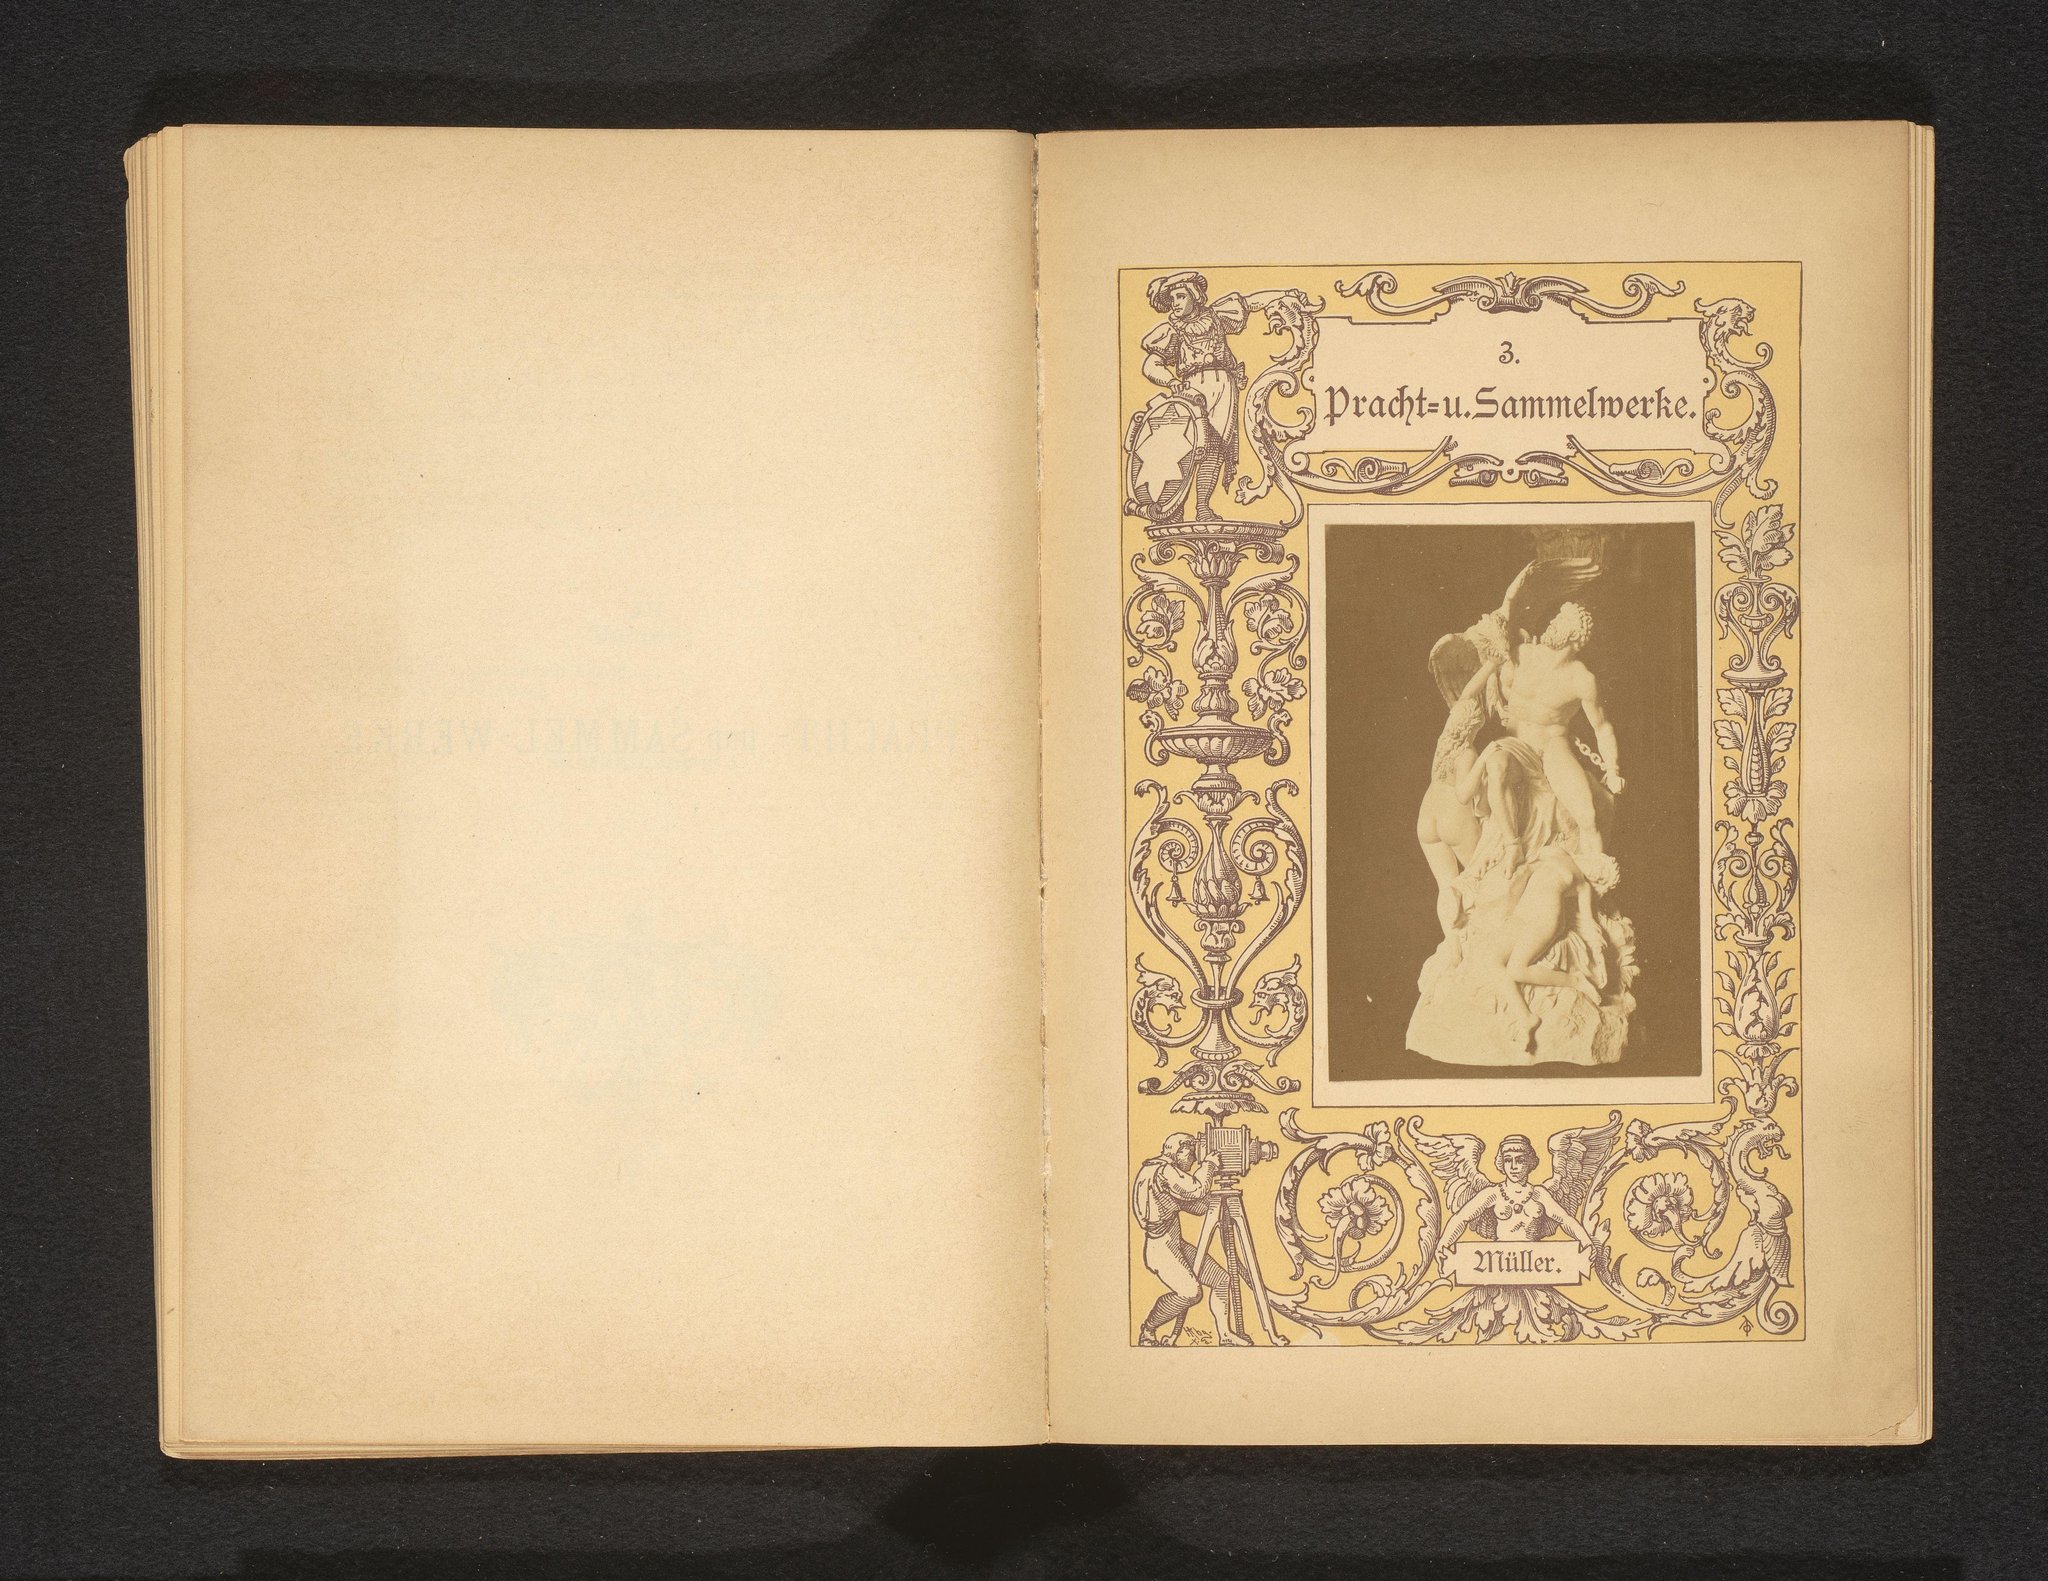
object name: page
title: Fotoreproductie van een sculptuur door Eduard Müller, voorstellend Prometheus en de Oceaniden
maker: eduard müller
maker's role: printer, publisher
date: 1873-1883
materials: photographic support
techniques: albumen print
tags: piece of sculpture, reproduction of a piece of sculpture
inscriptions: inscription: ‘3. Pracht=u. Sammelwerke.’